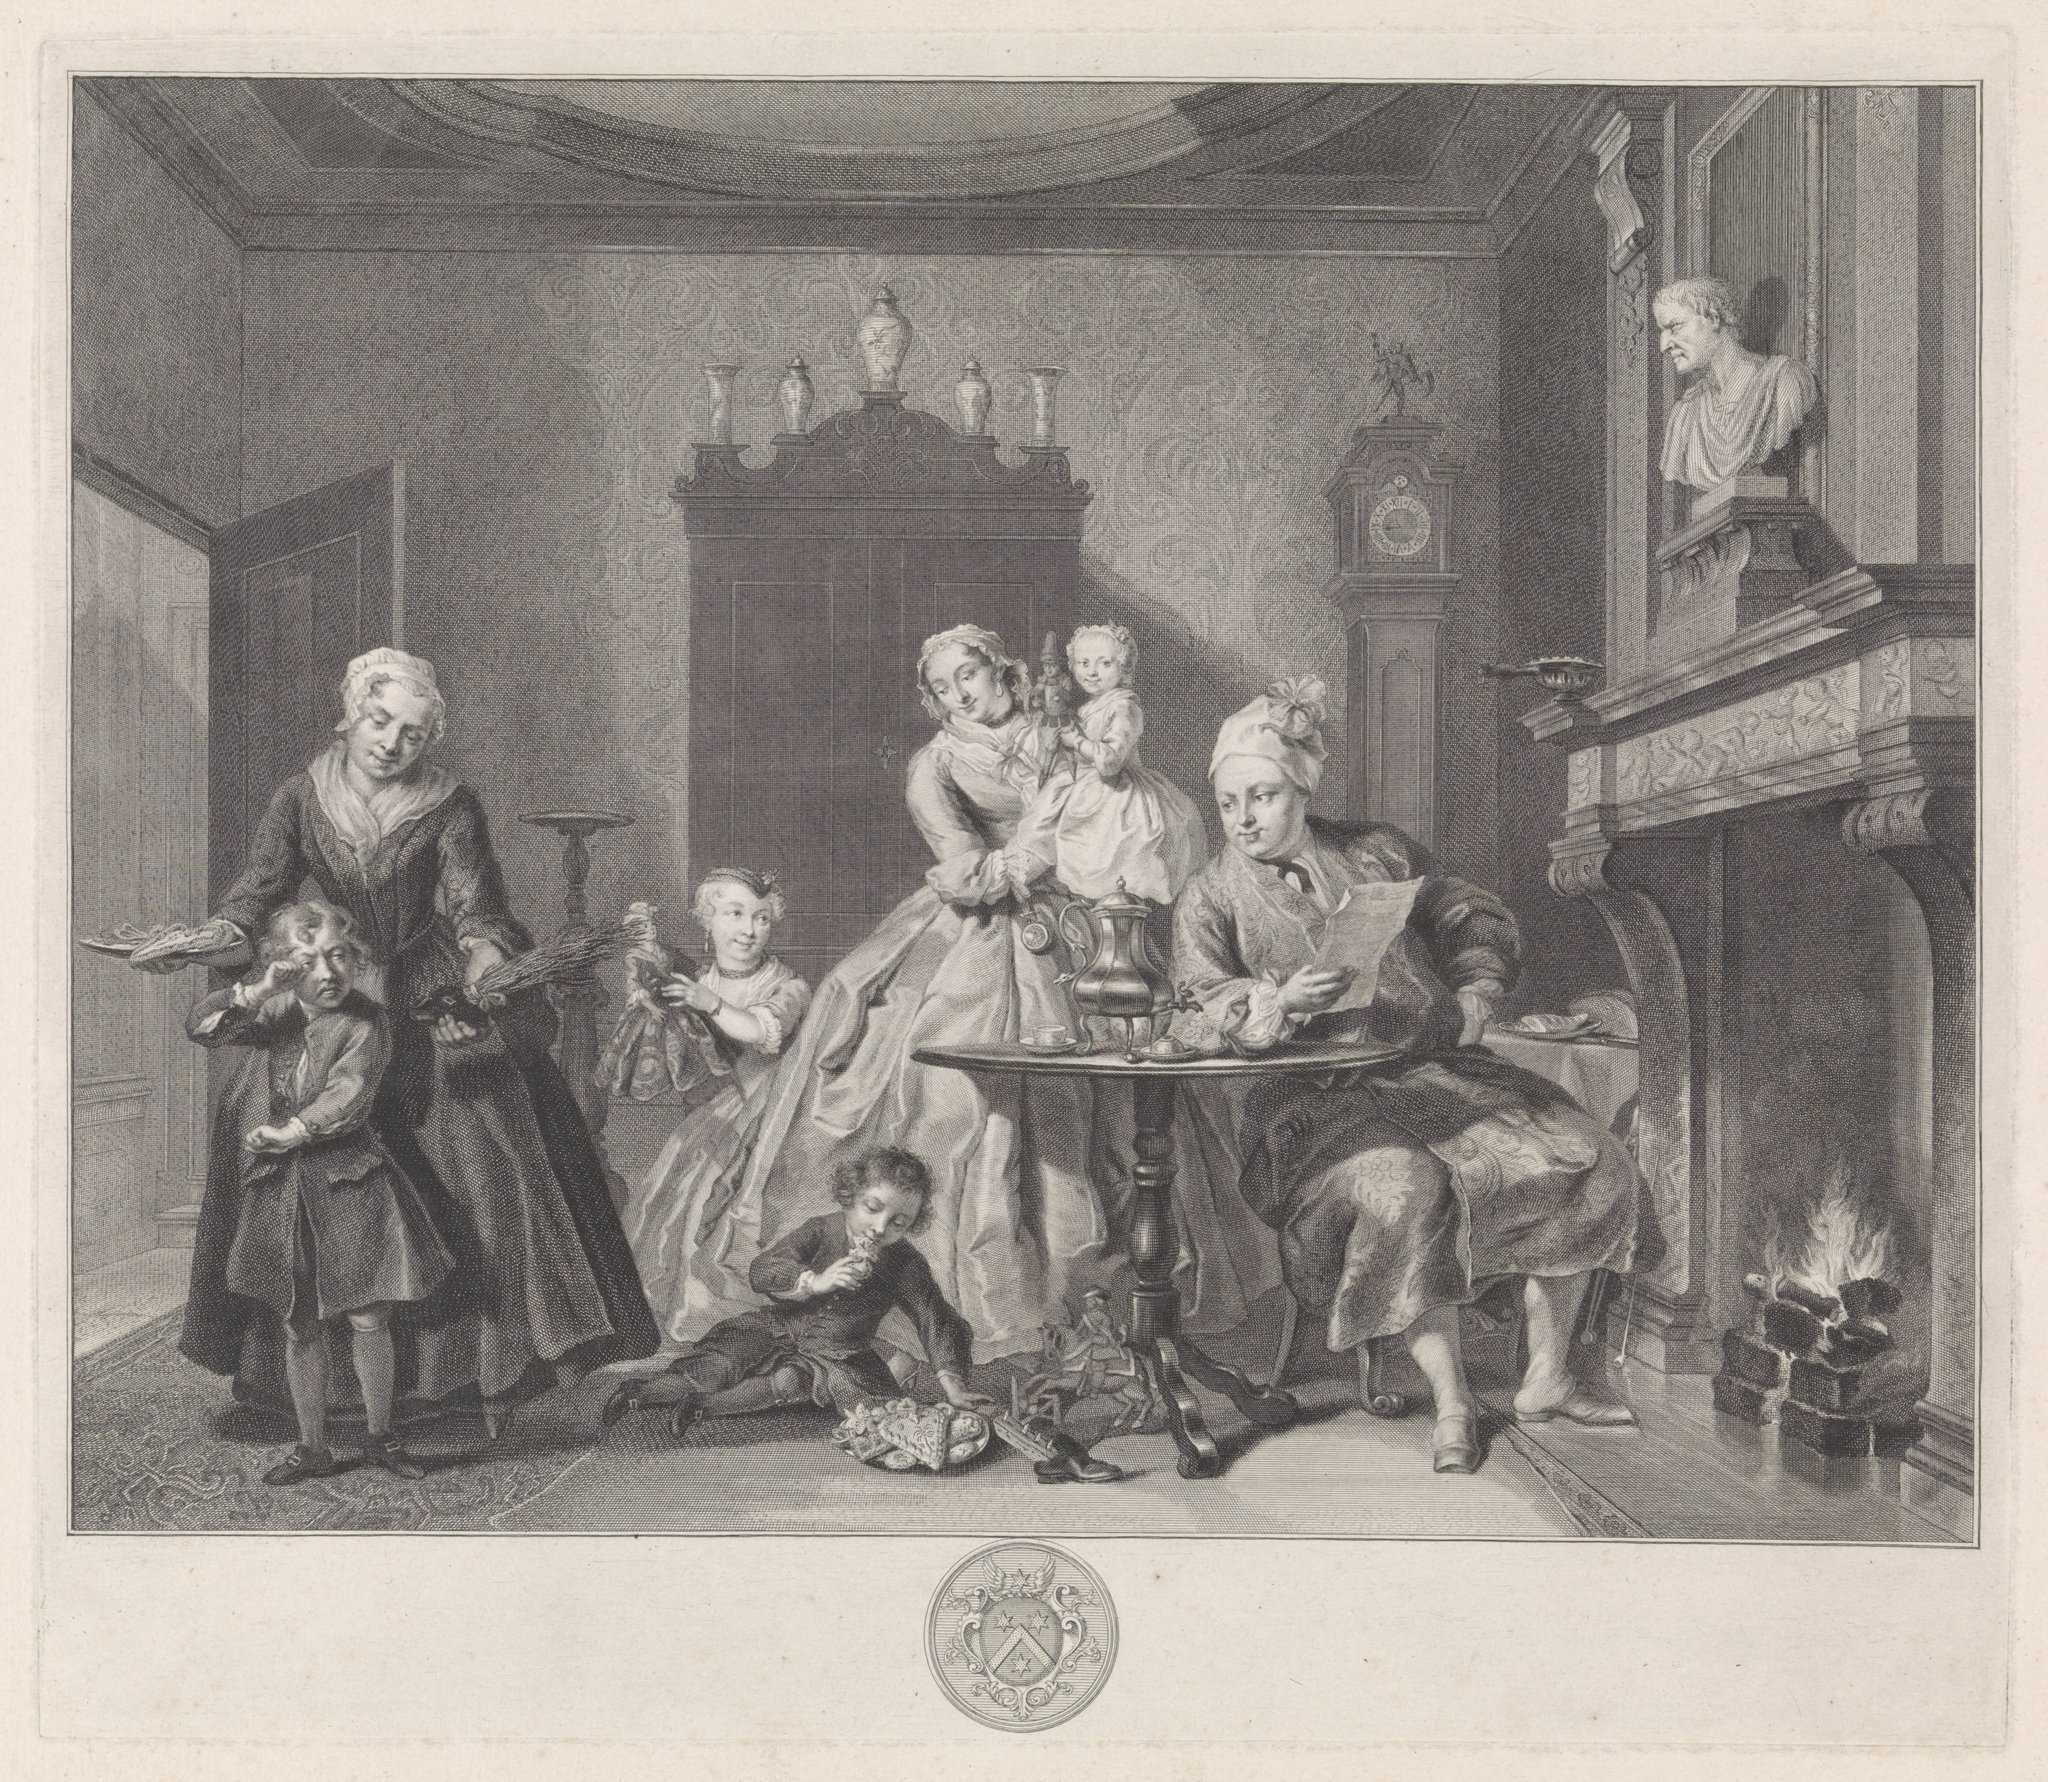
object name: print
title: Sint Nicolaasfeest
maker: jacob houbraken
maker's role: draughtsman, print maker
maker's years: 1698-1780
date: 1761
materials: paper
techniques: engraving, etching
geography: amsterdam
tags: parents with their children, cake, tart, pastry, open hearth, fire-place, (playing with) dolls, festivities on st. nicholas (eve) (december 5)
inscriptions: collector's mark: Lugt 240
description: In een interieur viert een gezin het Sint Nicolaasfeest. De vader zit bij de haard te lezen, achter hem laten twee dochters hun poppen zien die ze hebben gekregen. Op de grond snoept een kind met een schaal met koek en snoepgoed. Links een huilende jongen die alleen een roe heeft gekregen; de dienstmeid achter hem heeft zijn schoen met daarin de roe vast.